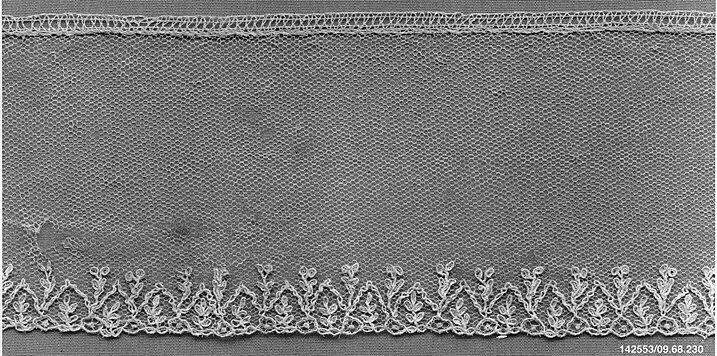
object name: border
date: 1801-1833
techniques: lace